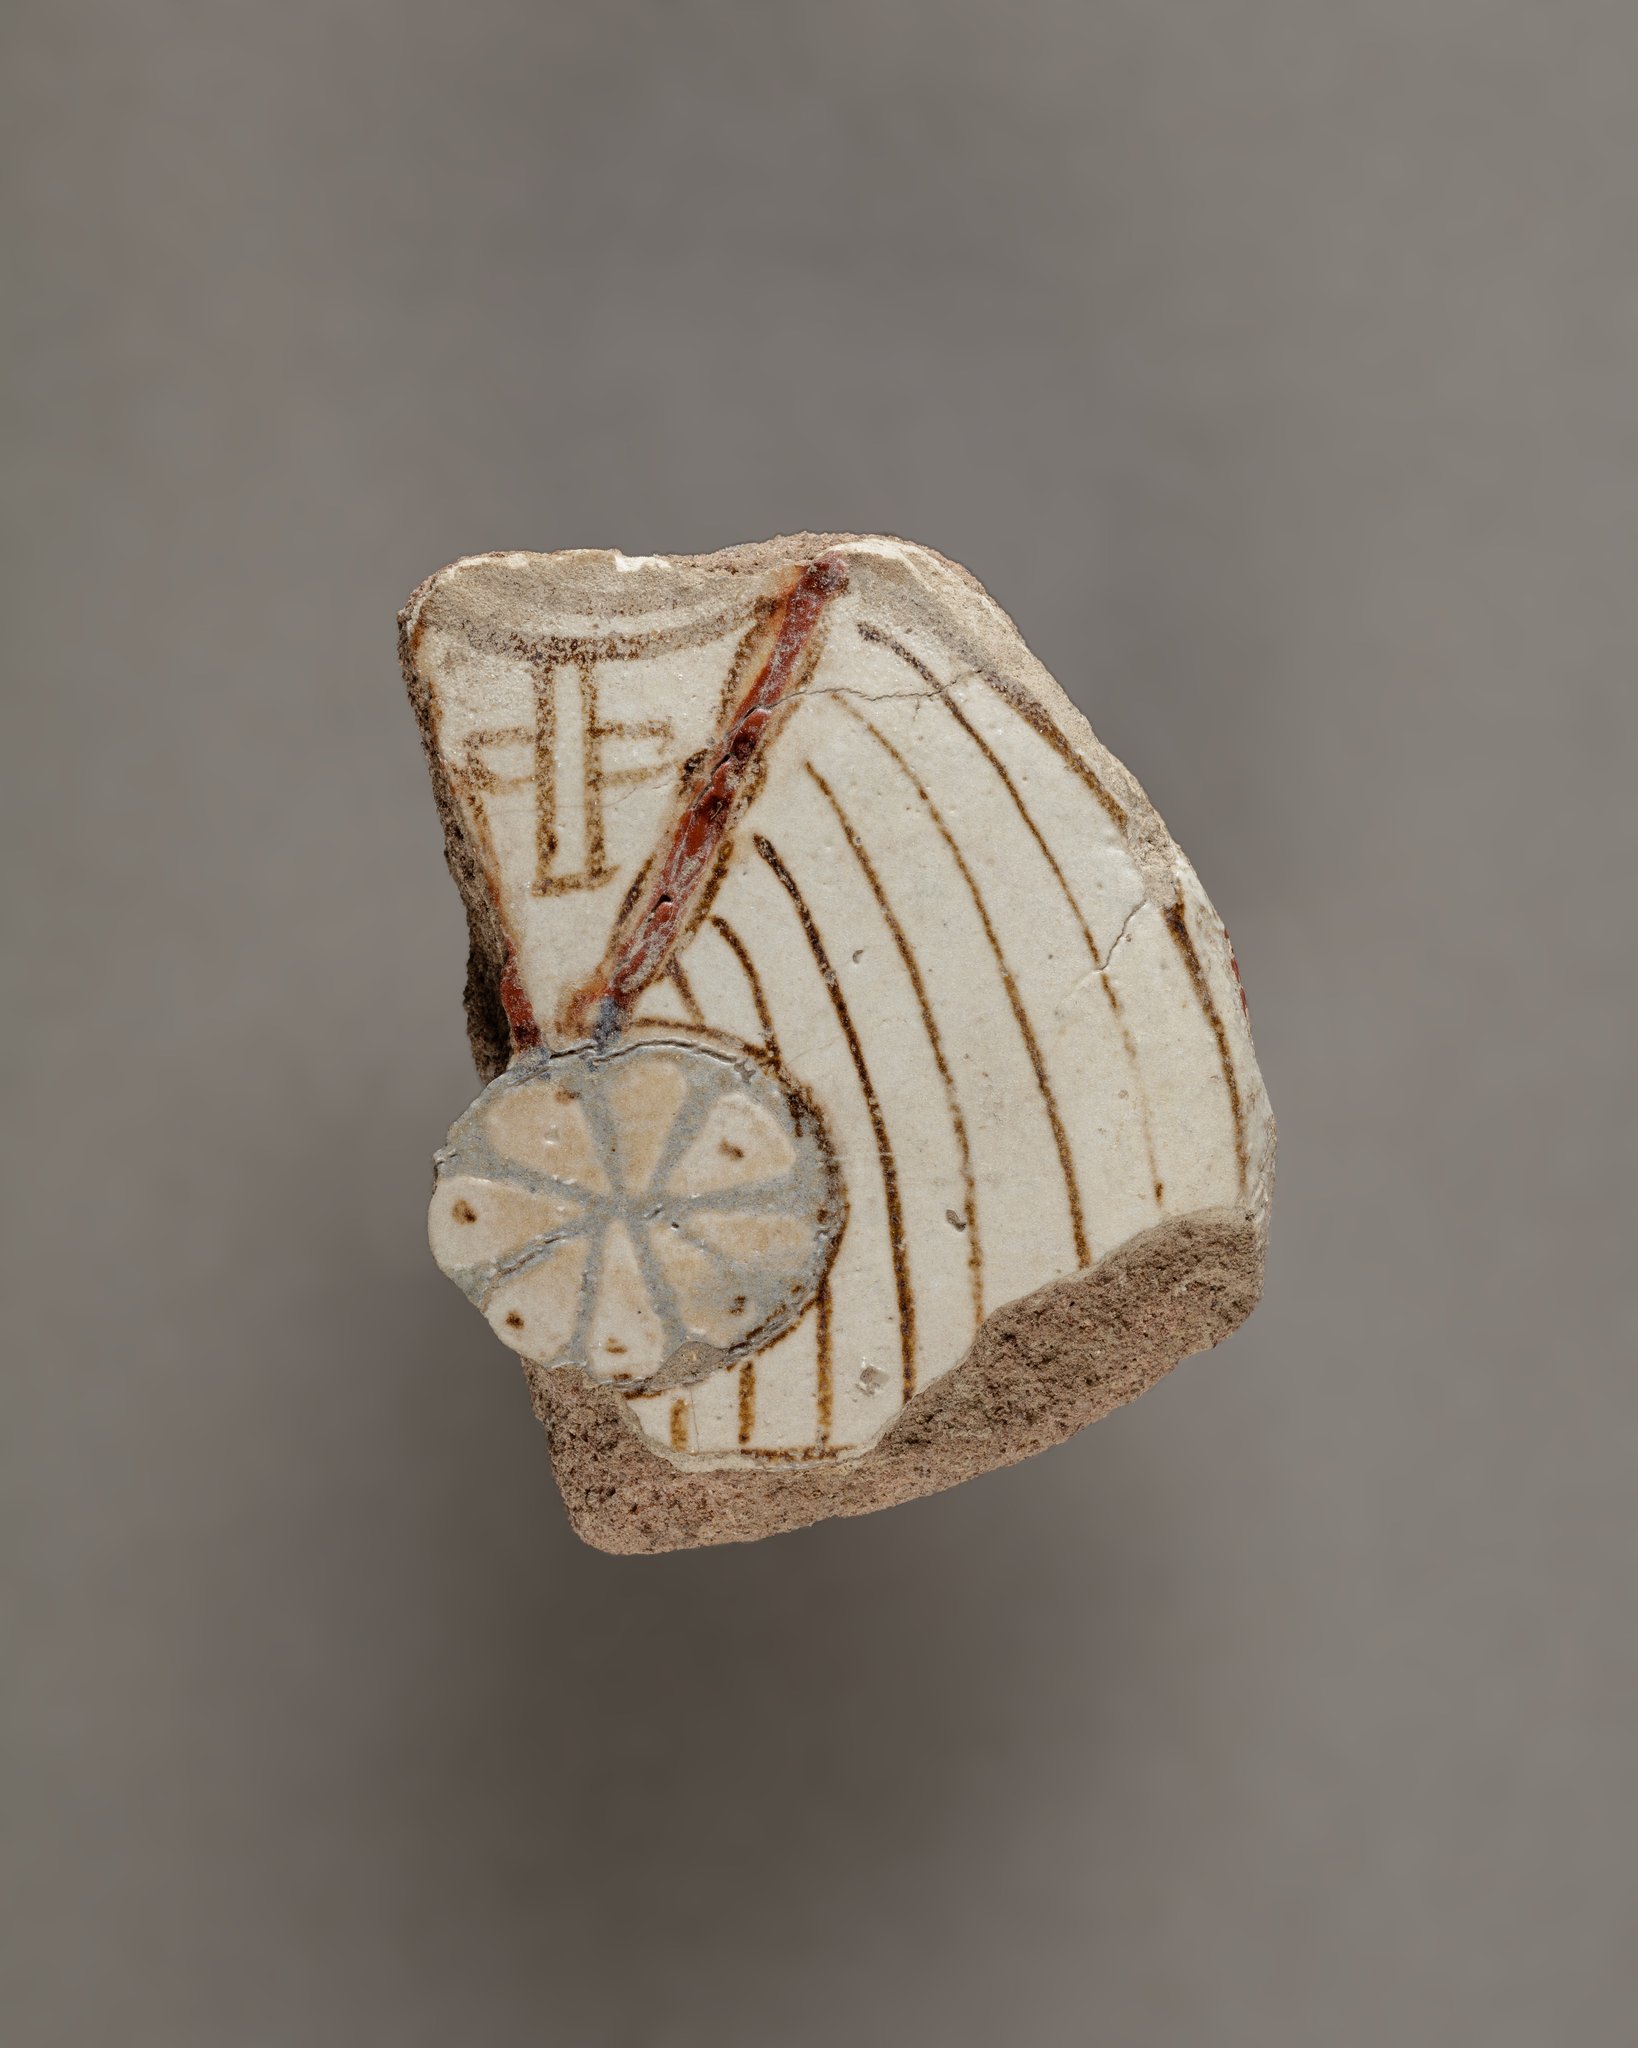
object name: tile inlay, palace of ramesses ii, foreigner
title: Tile fragment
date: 1279-1213 BCE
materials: ceramic, glaze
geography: egypt